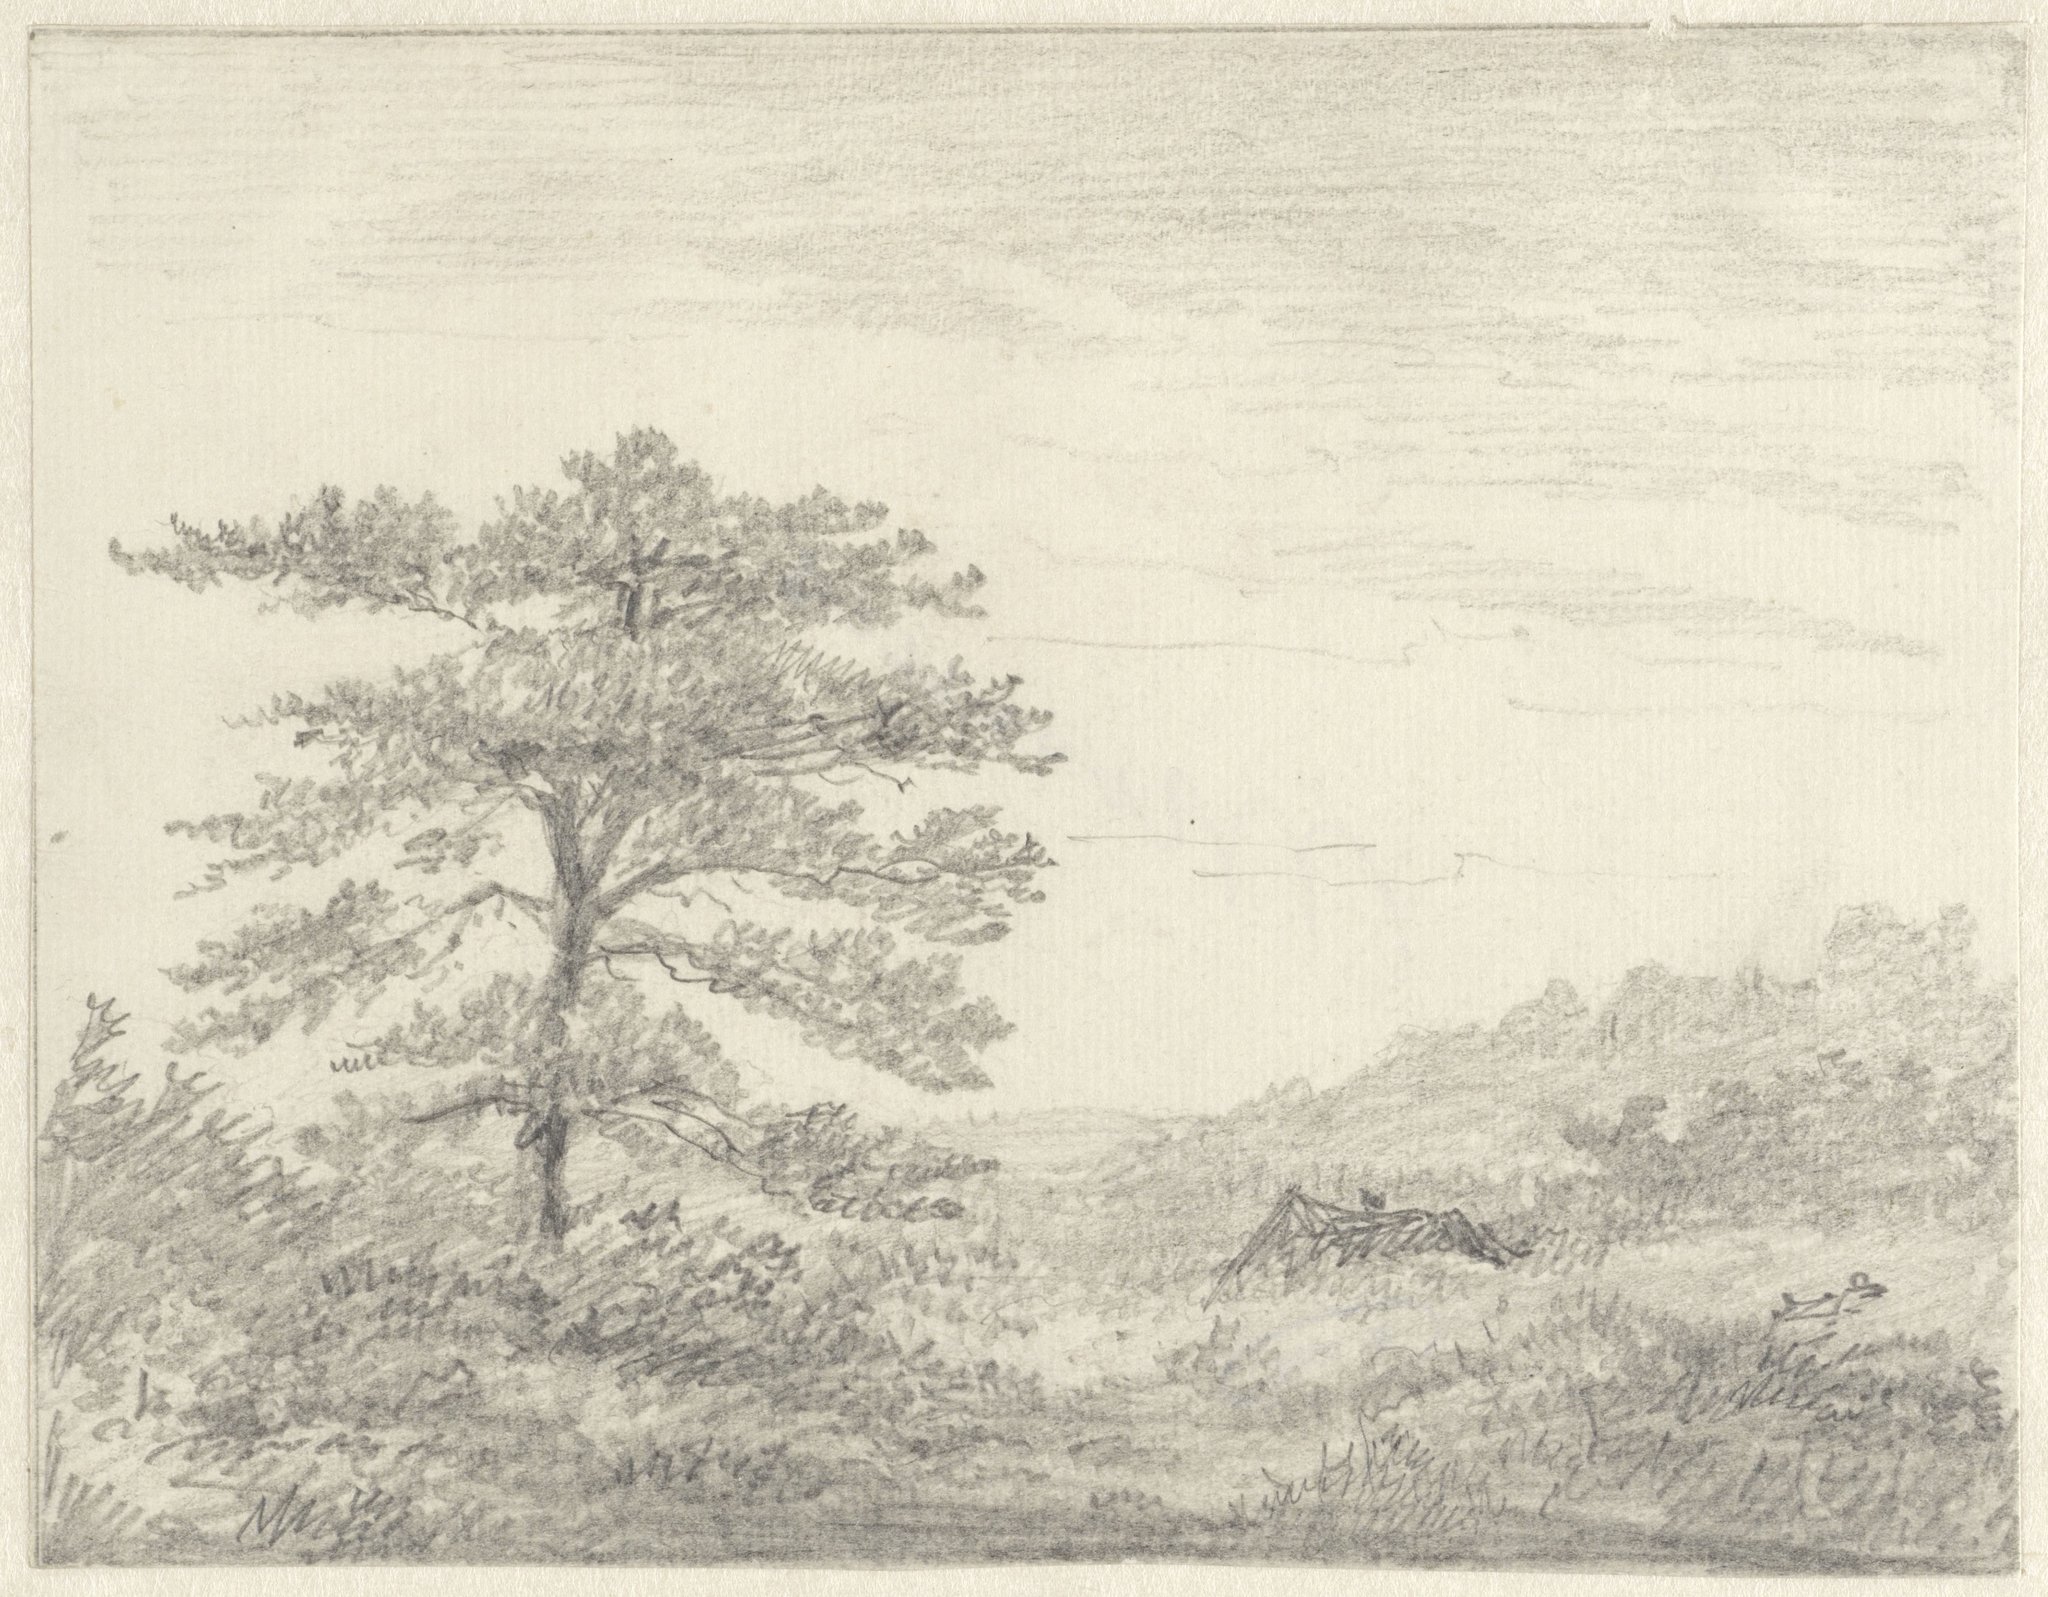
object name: drawing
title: Landschap met hut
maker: christiaan wilhelmus moorrees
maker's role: draughtsman, print maker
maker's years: 1801-1867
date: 1811-1867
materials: paper, pencil